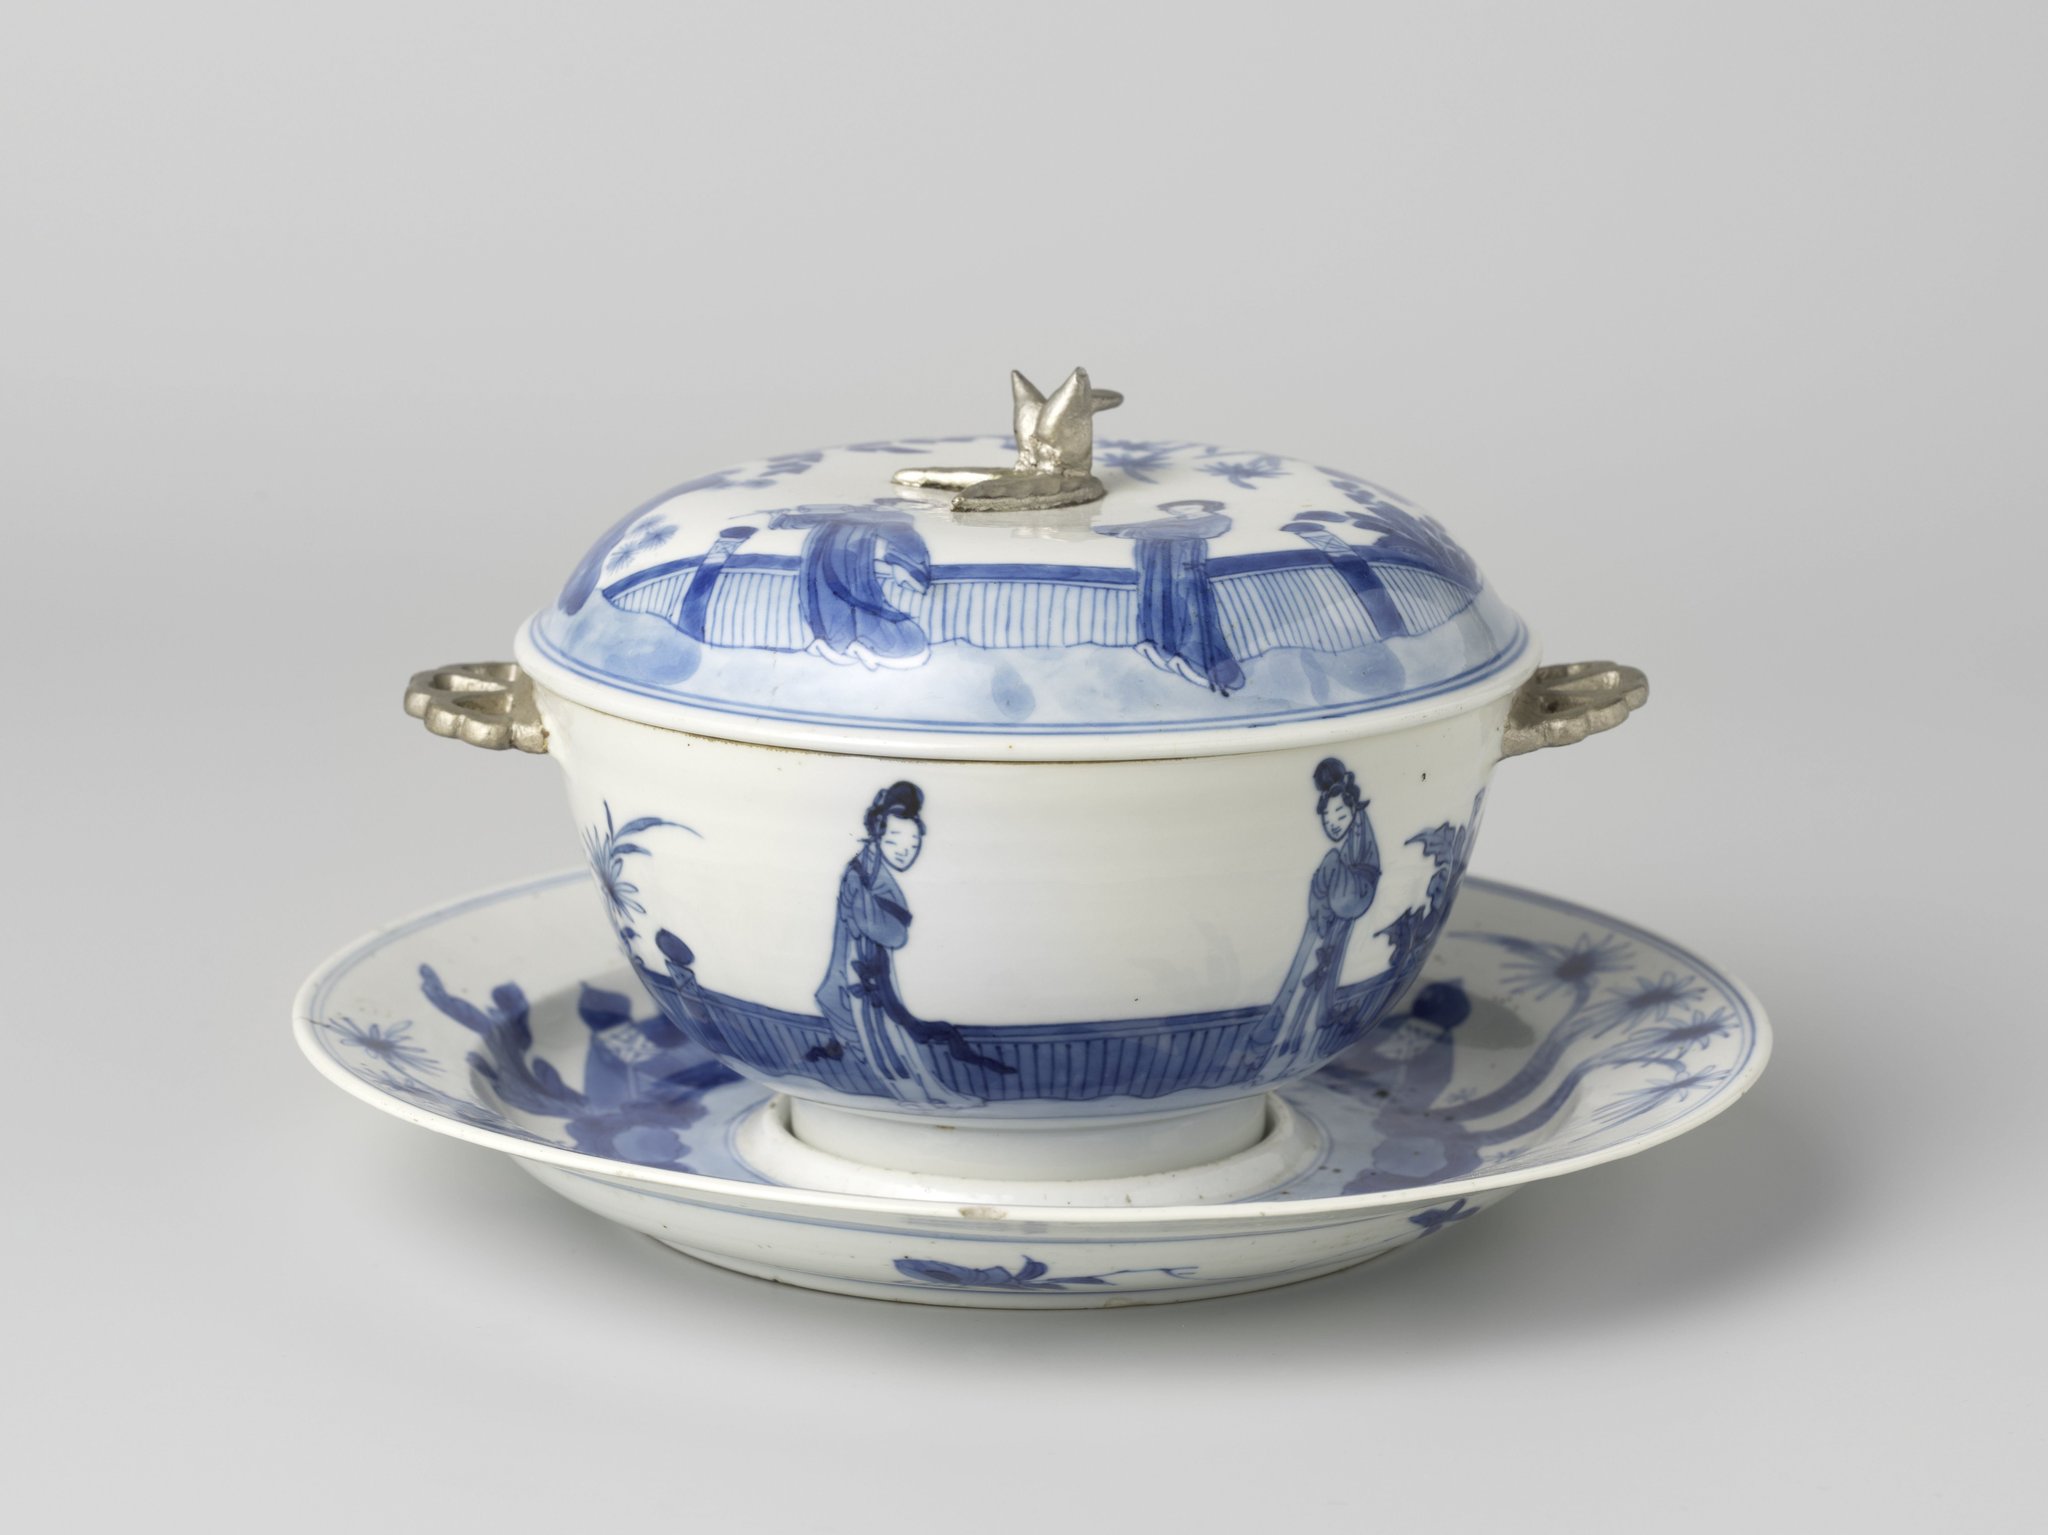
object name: lid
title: Covered bowl with stand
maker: Anonymous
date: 1700-1724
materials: biscuit porcelain, cobalt, glaze, material), metal, paint, porcelain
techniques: firing, turning, vitrification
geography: china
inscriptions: mark: ‘大 清 康 熙 年 製’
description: Deksel met knop van metaal van kom van porselein met halve bloemvormige oren, beschilderd in onderglazuur blauw. Doorlopende voorstelling van een omheind terras met twee maal twee vrouwen (lange lijzen) afgebeeld, één vrouw met waaier. Knop later in Europa verzilverd. Blauw-wit.